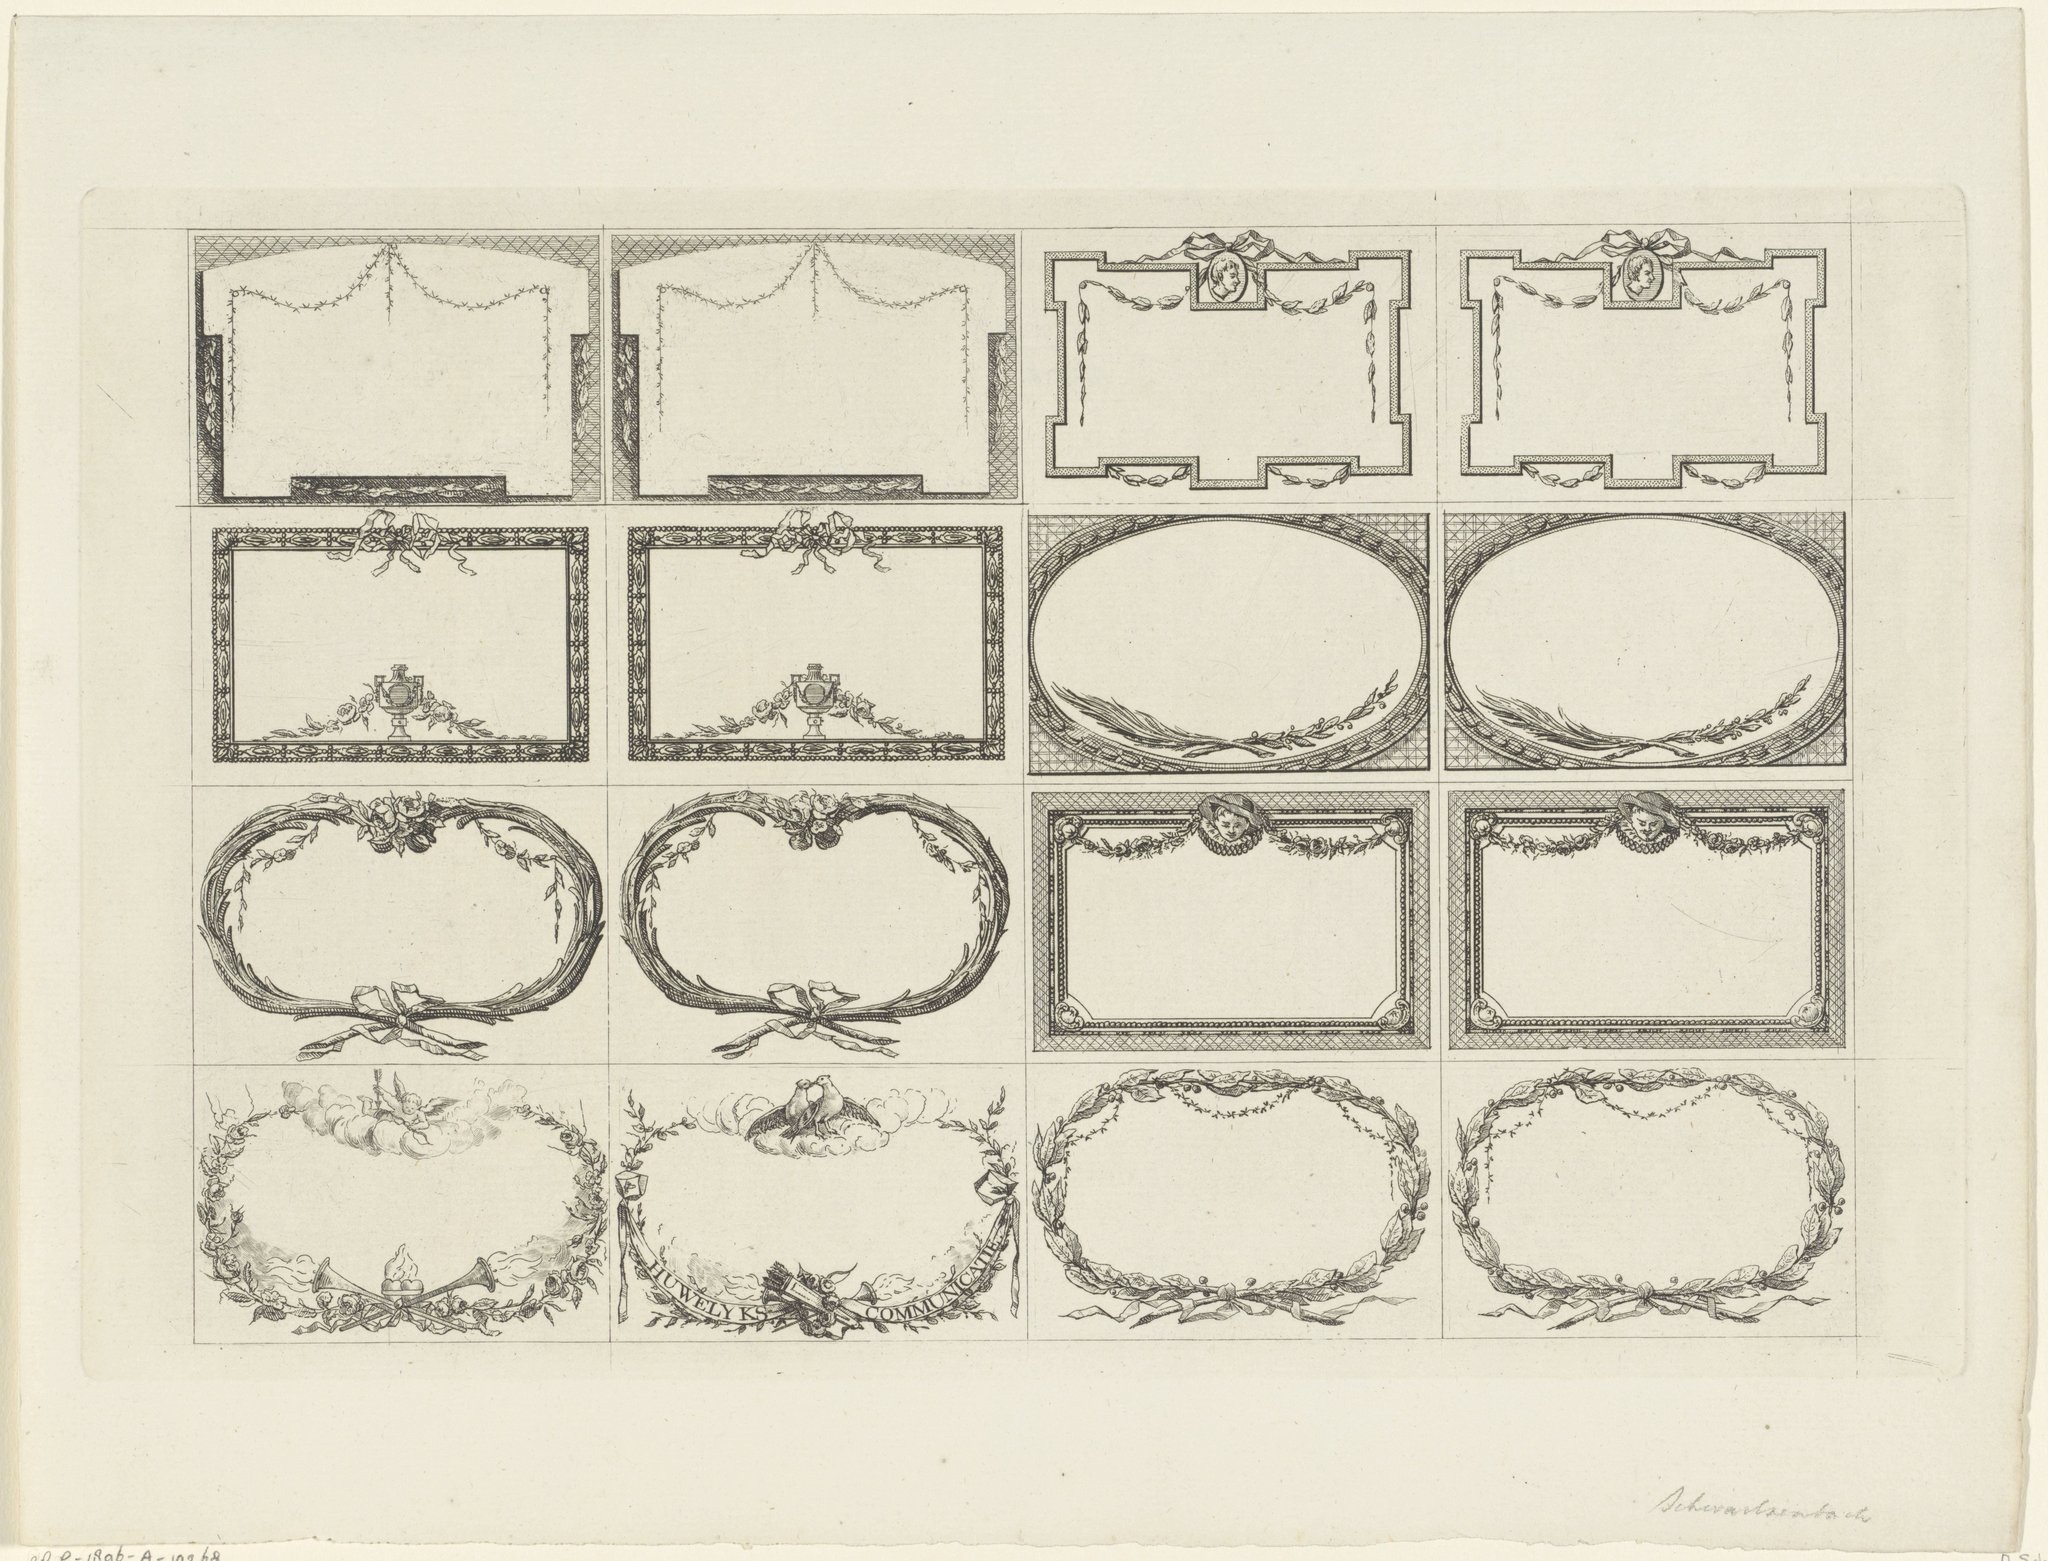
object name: print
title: Blad met zestien verschillende cartouches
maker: jacob schwartzenbach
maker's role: draughtsman, painter, print maker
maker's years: 1763-1805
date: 1773-1805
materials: paper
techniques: etching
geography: veere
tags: ornaments ~ art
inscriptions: collector's mark: Lugt 2228